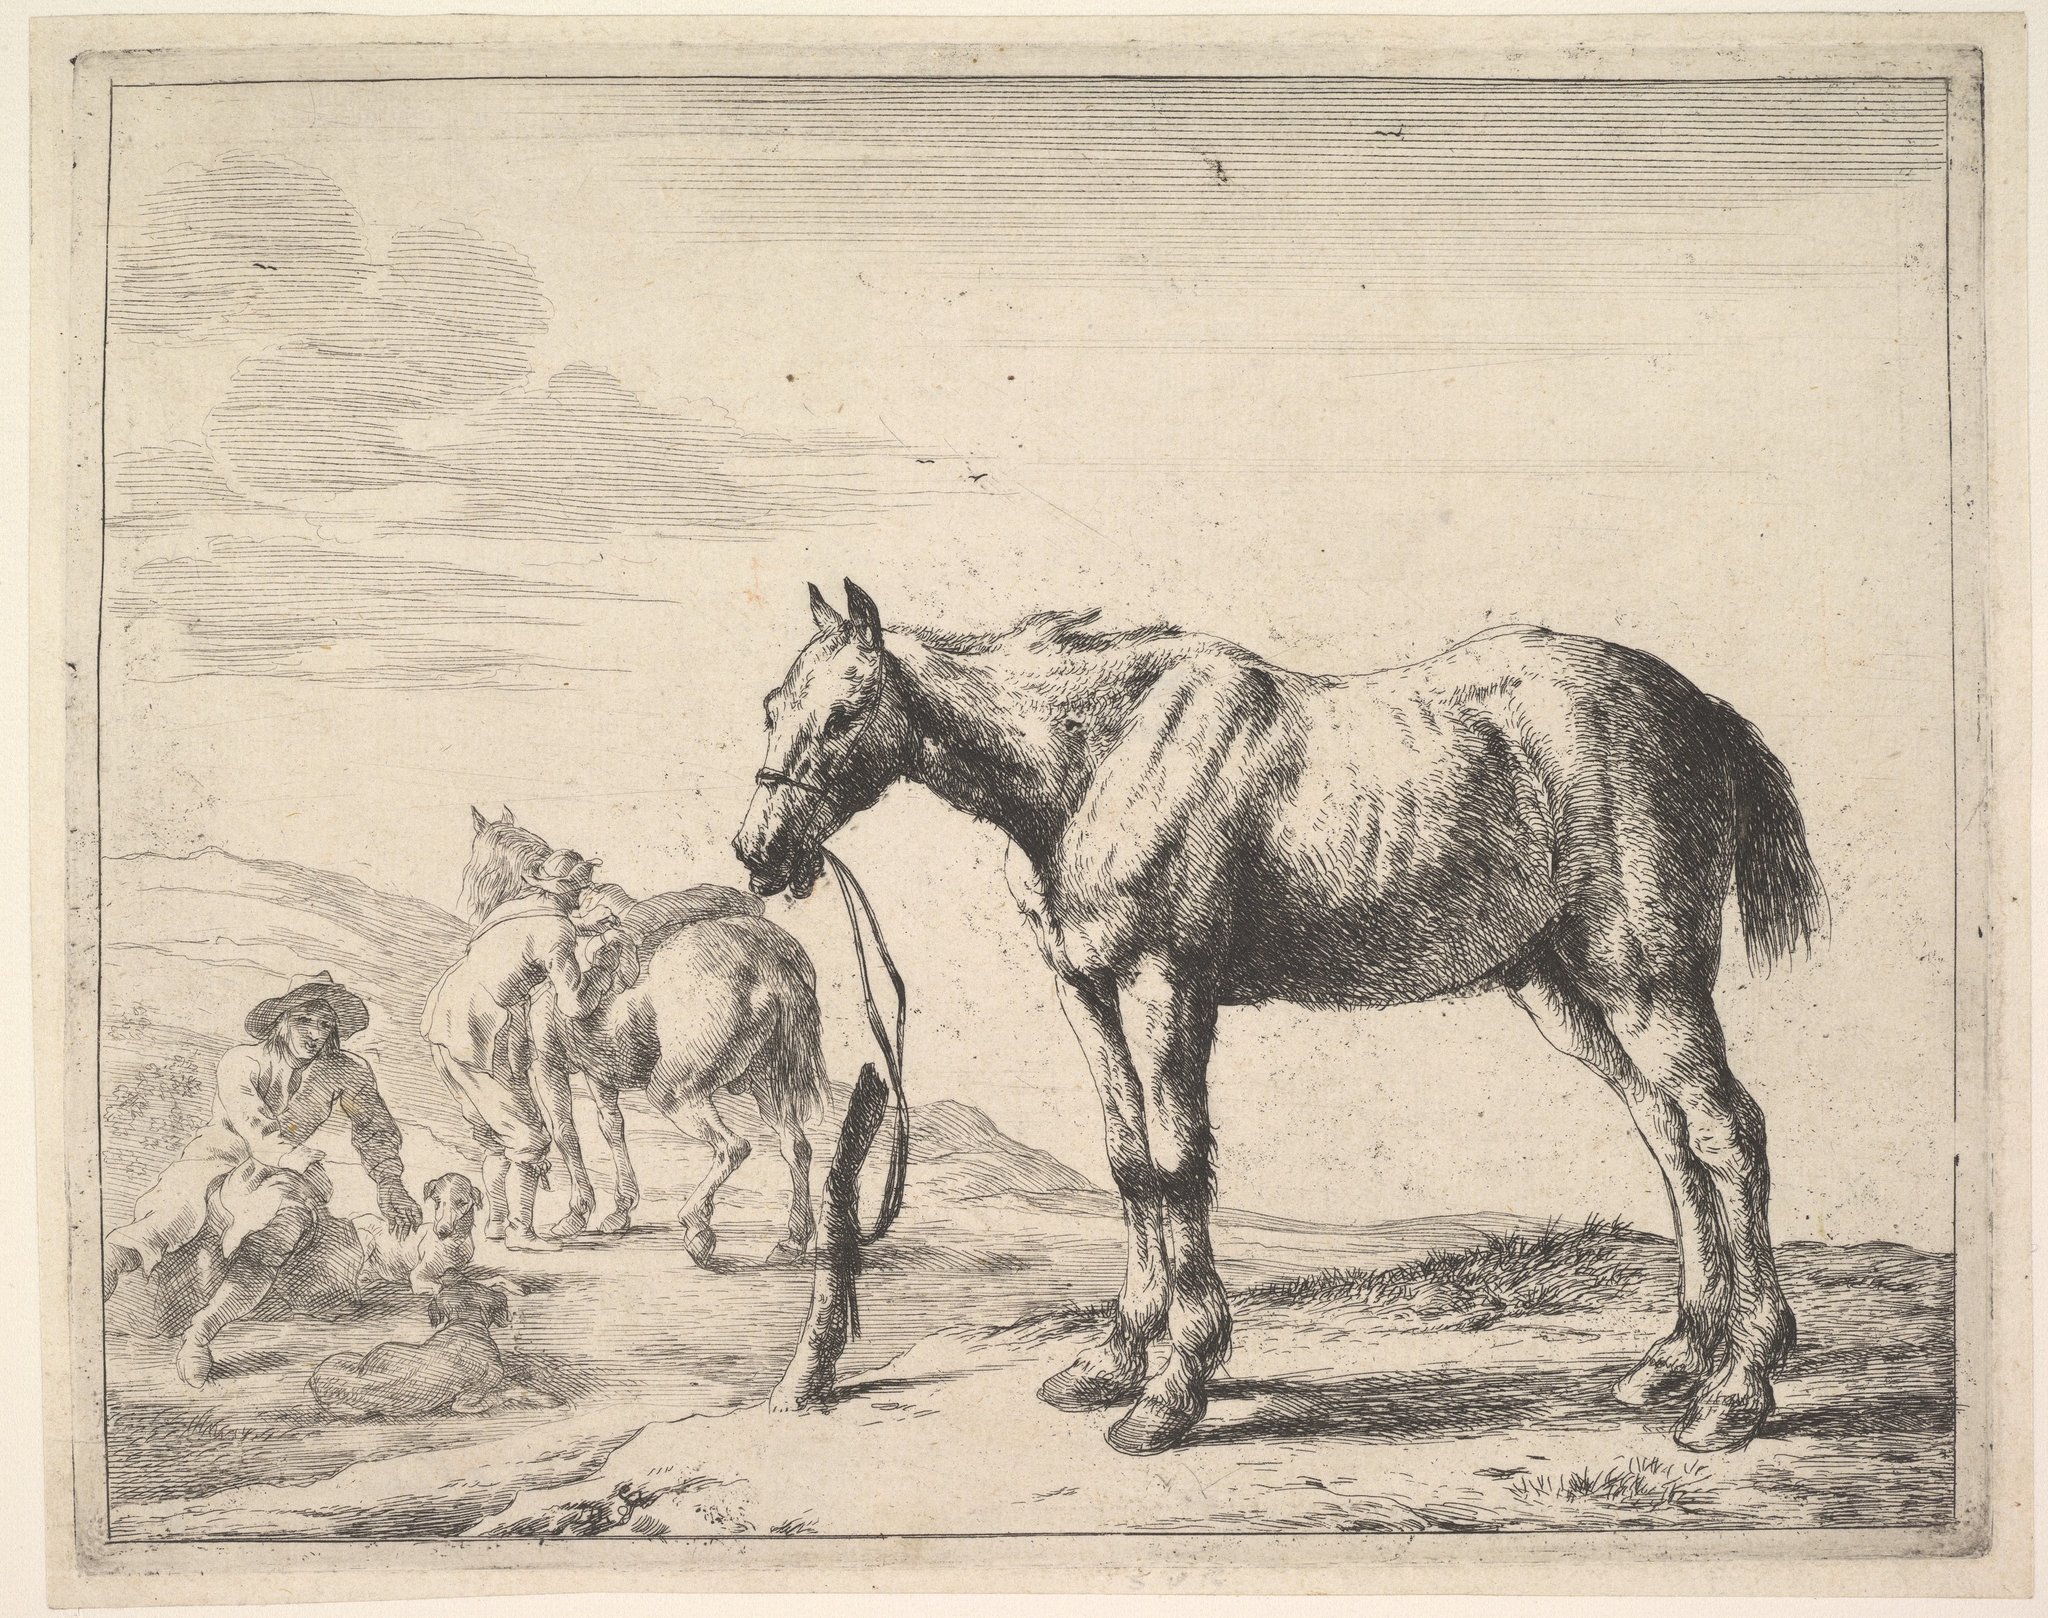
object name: print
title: Horse Bound to a Post, turned left, from "The Horses"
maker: dirck stoop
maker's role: artist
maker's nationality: dutch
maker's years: 1610-1686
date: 1610-1686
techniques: etching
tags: dogs,horses